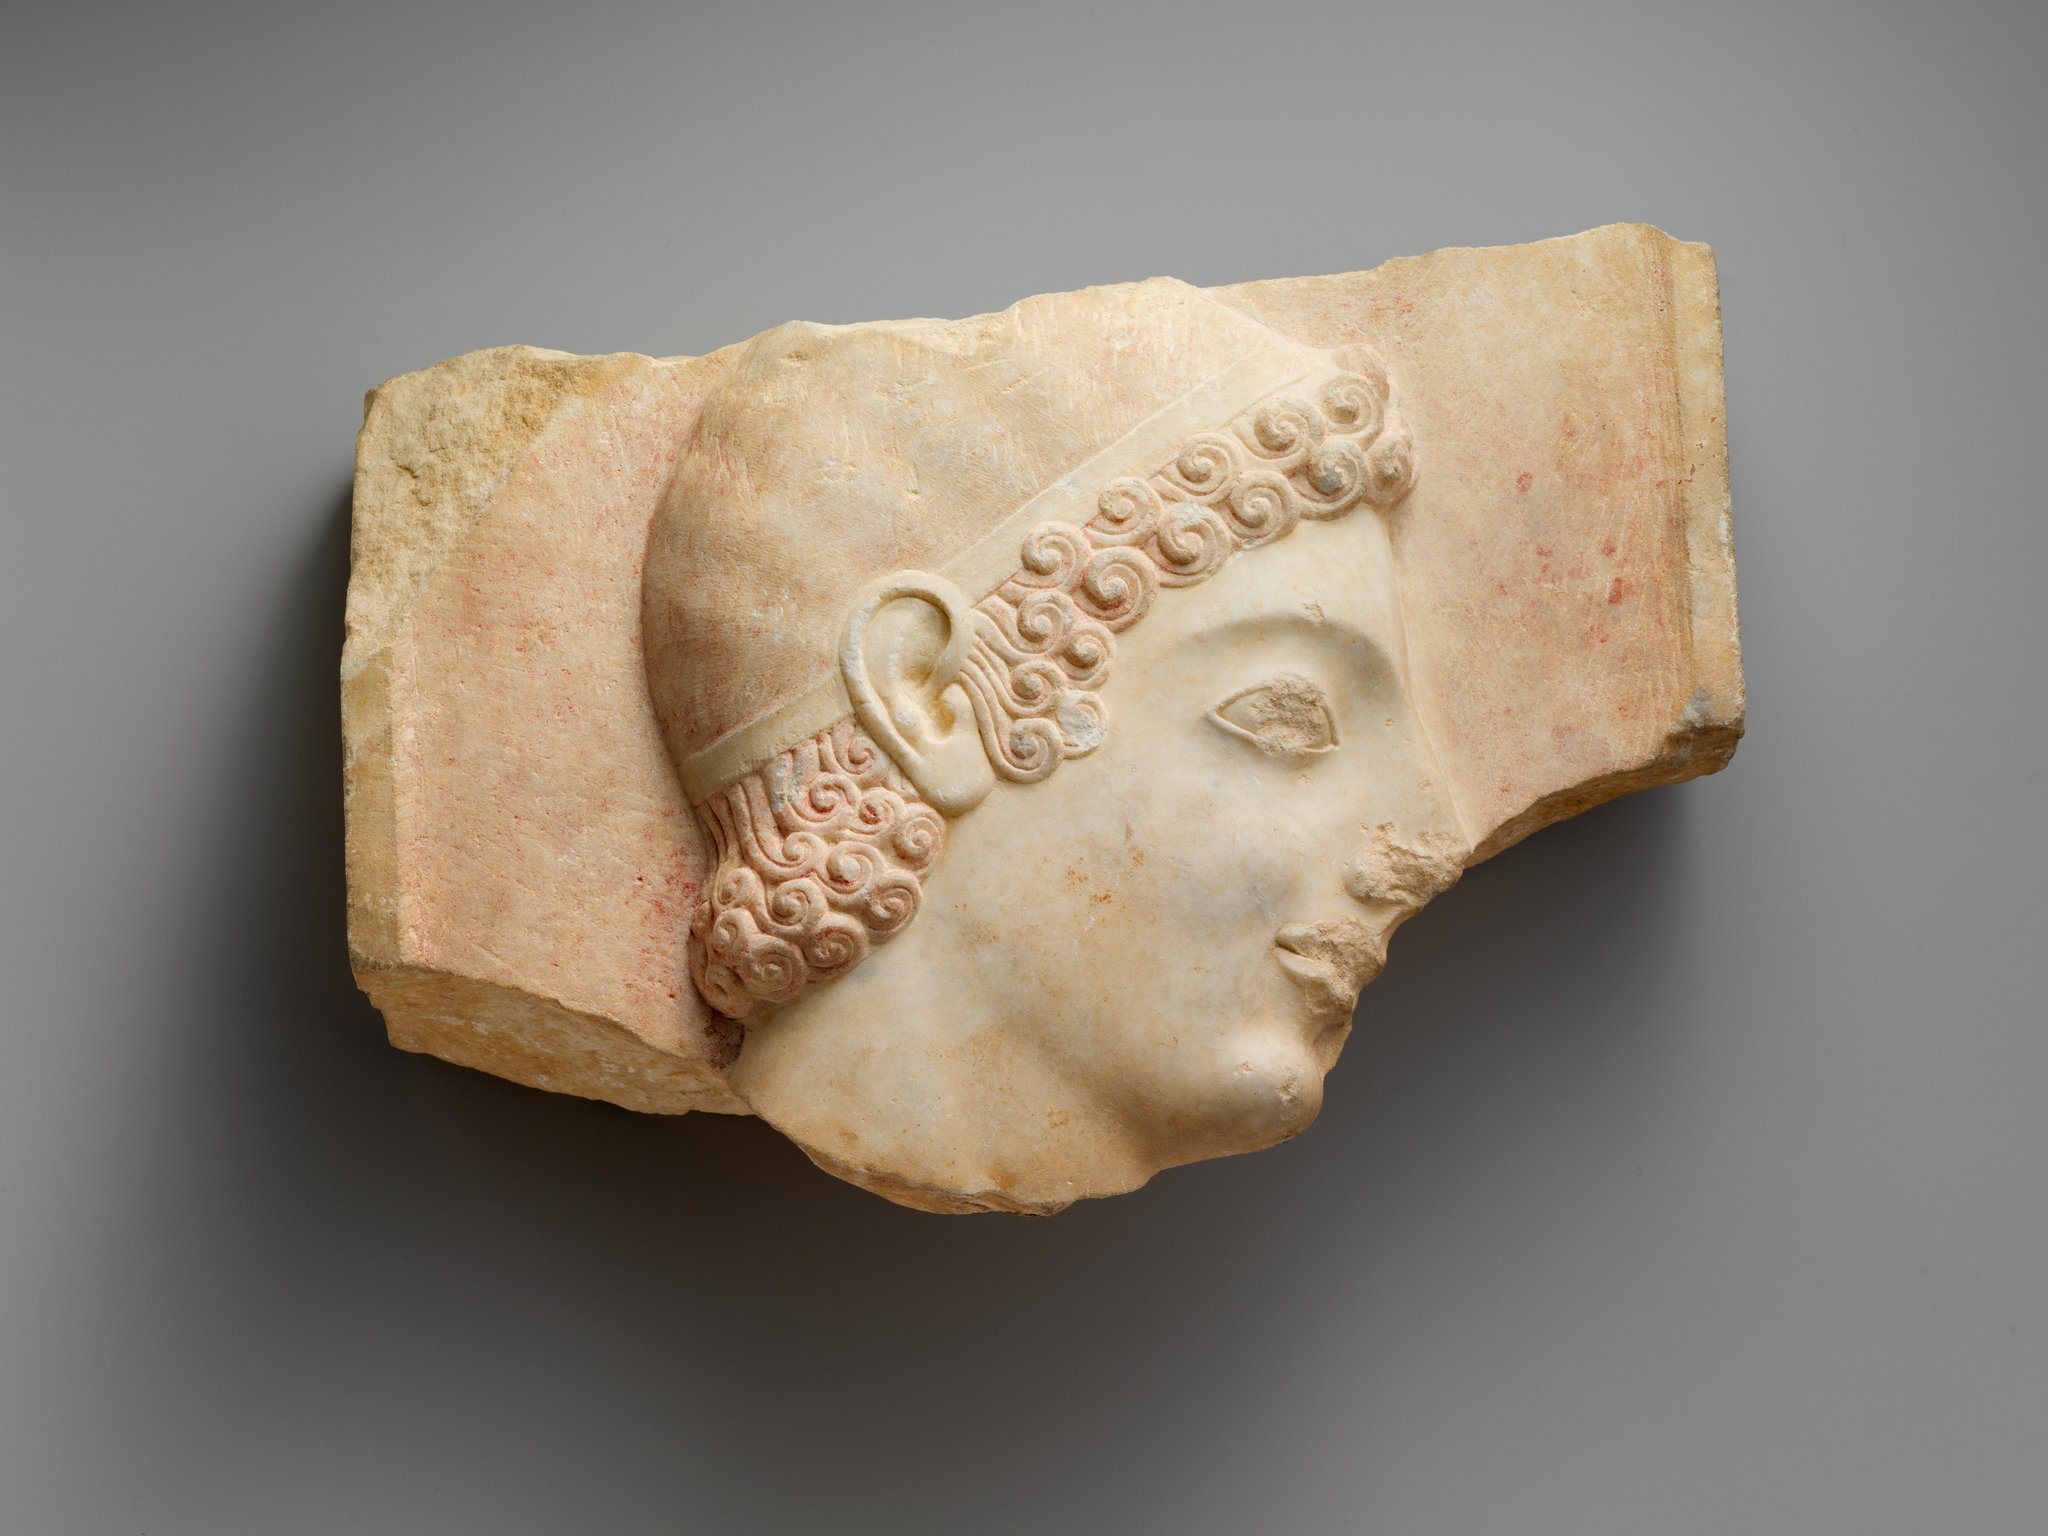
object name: grave stele fragment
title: Head of a youth from a marble stele (grave marker)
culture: greek, attic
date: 525 BCE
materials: marble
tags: heads,men